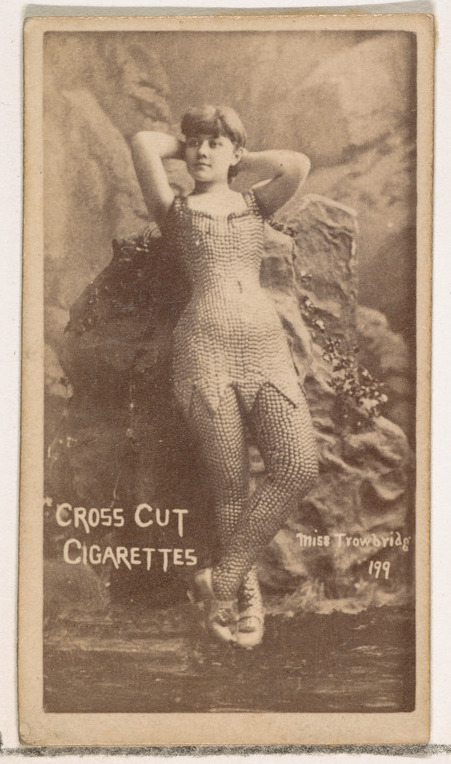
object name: print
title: Card Number 199, Miss Trowbridge, from the Actors and Actresses series (N145-1) issued by Duke Sons & Co. to promote Cross Cut Cigarettes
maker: w. duke, sons & co.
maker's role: publisher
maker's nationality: american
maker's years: 1870-1920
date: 1880-1889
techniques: albumen silver print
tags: portraits,women,actresses